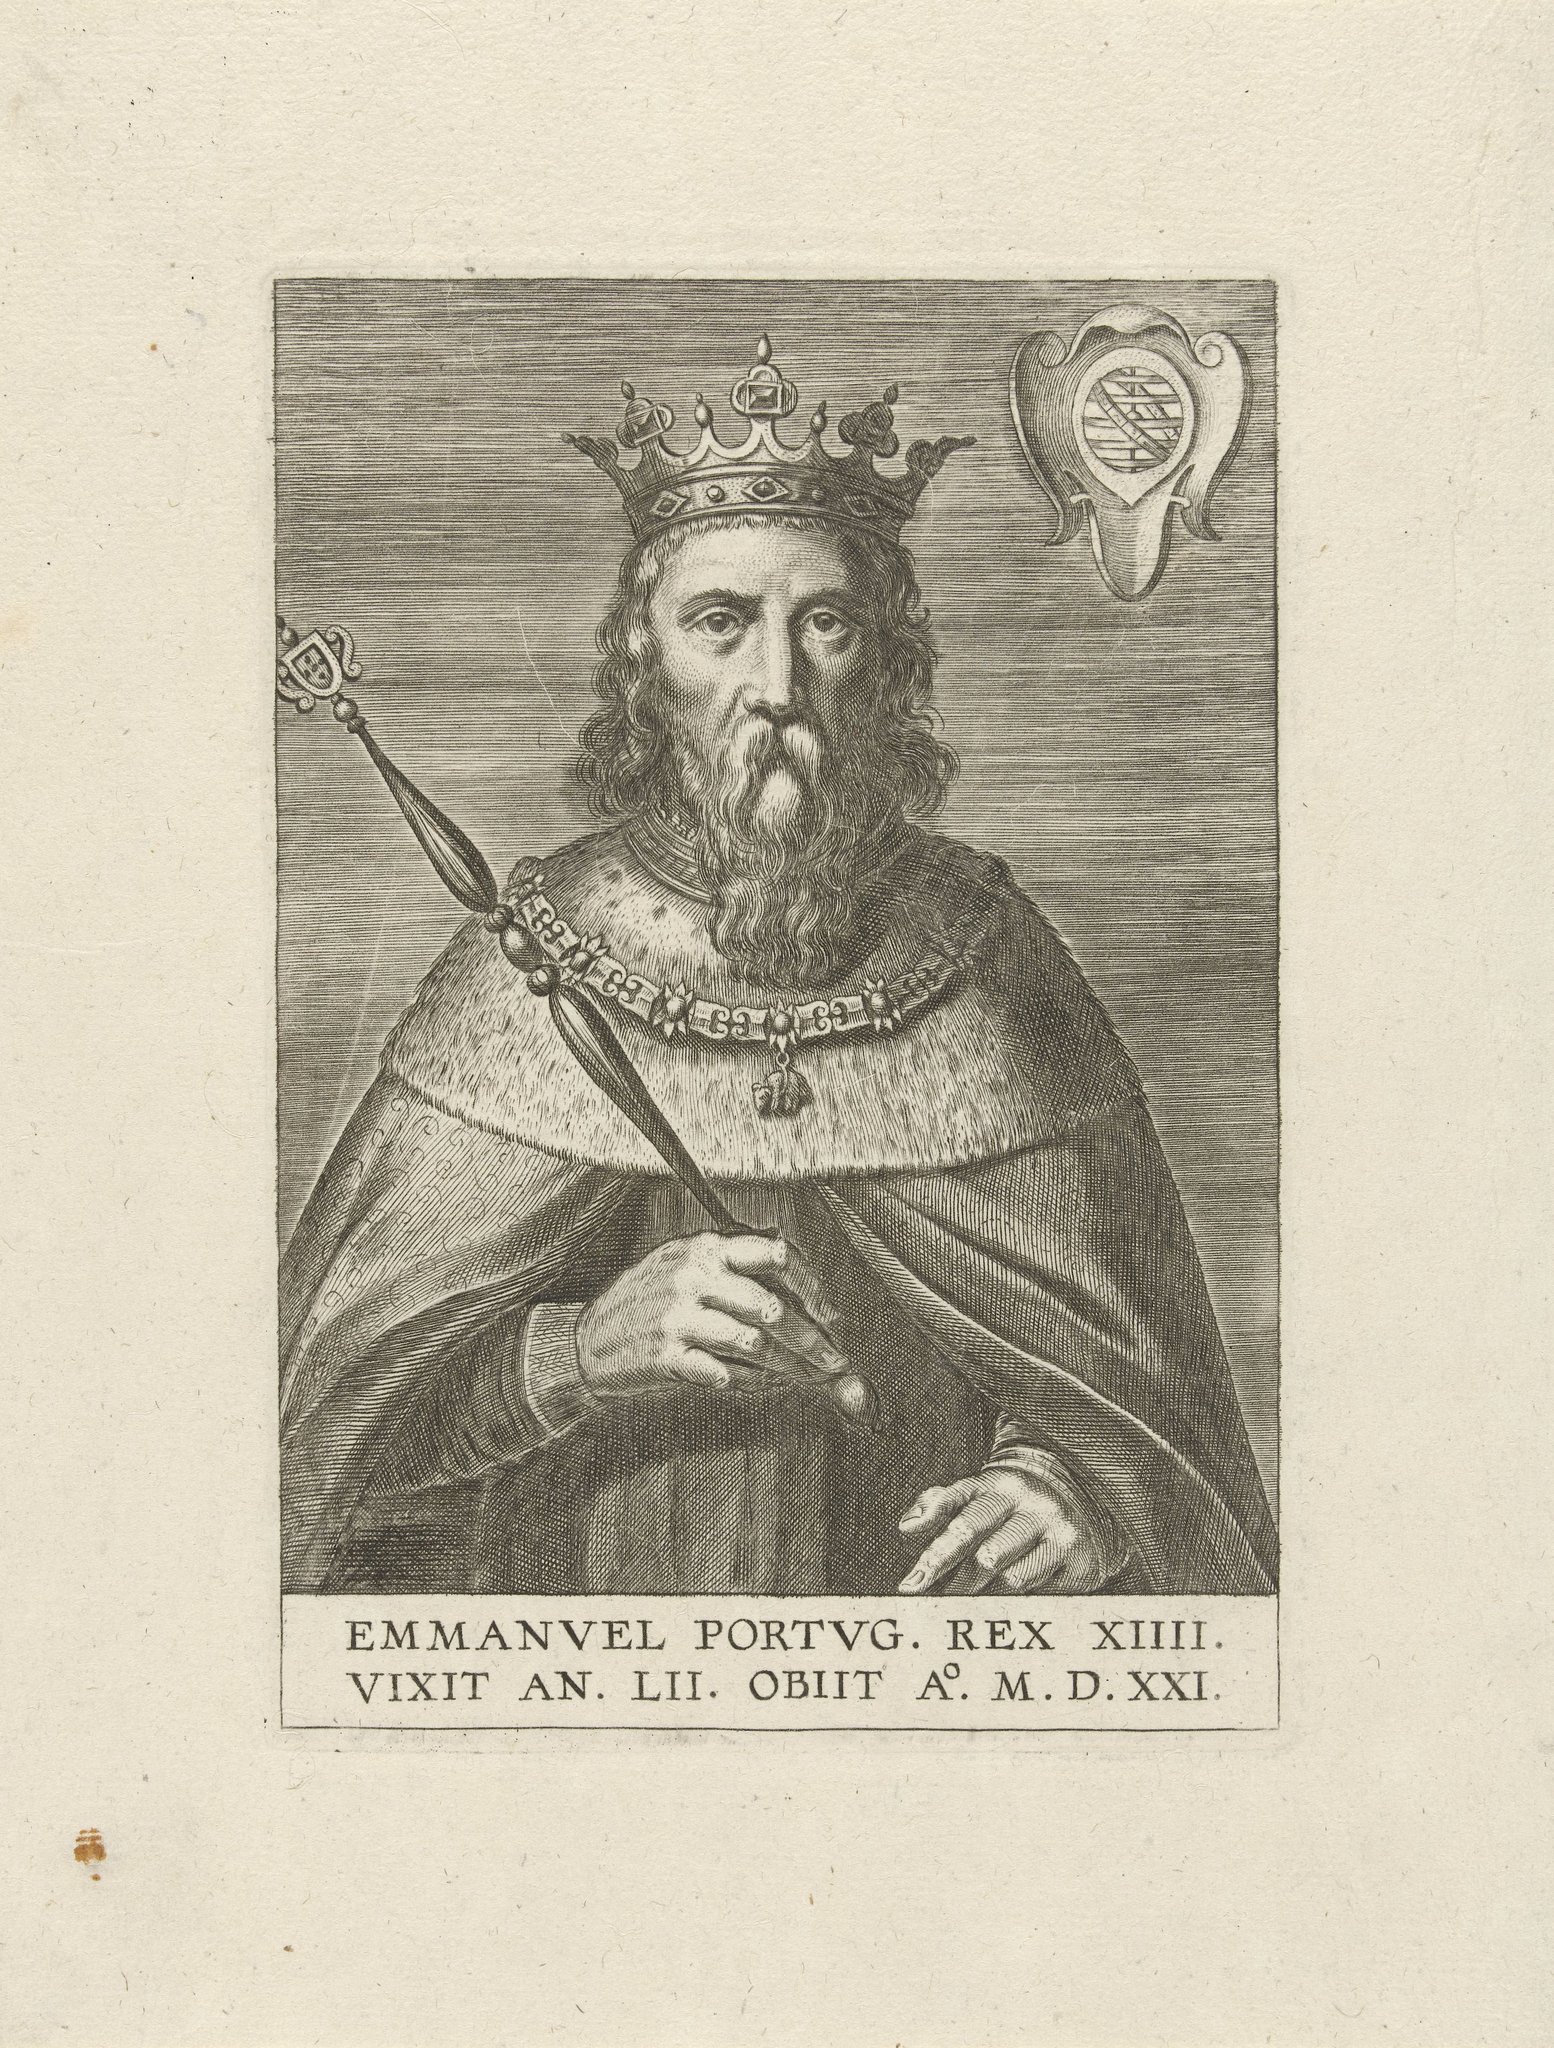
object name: print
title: Koningen en prinsen van Portugal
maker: cornelis galle (i)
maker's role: print maker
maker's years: 1576-1650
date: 1621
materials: paper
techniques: engraving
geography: southern netherlands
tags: lissabon, koning, emanuel i (koning van portugal), portugal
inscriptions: collector's mark: Lugt 2228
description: Illustratie voor: Antonio Vasconcellos. Anacephalæoses id est, Svmma captia actorvm regvm Lvsitaniæ. Antwerpen: Petrus II en Joannes II Bellerus, 1621, of latere druk.